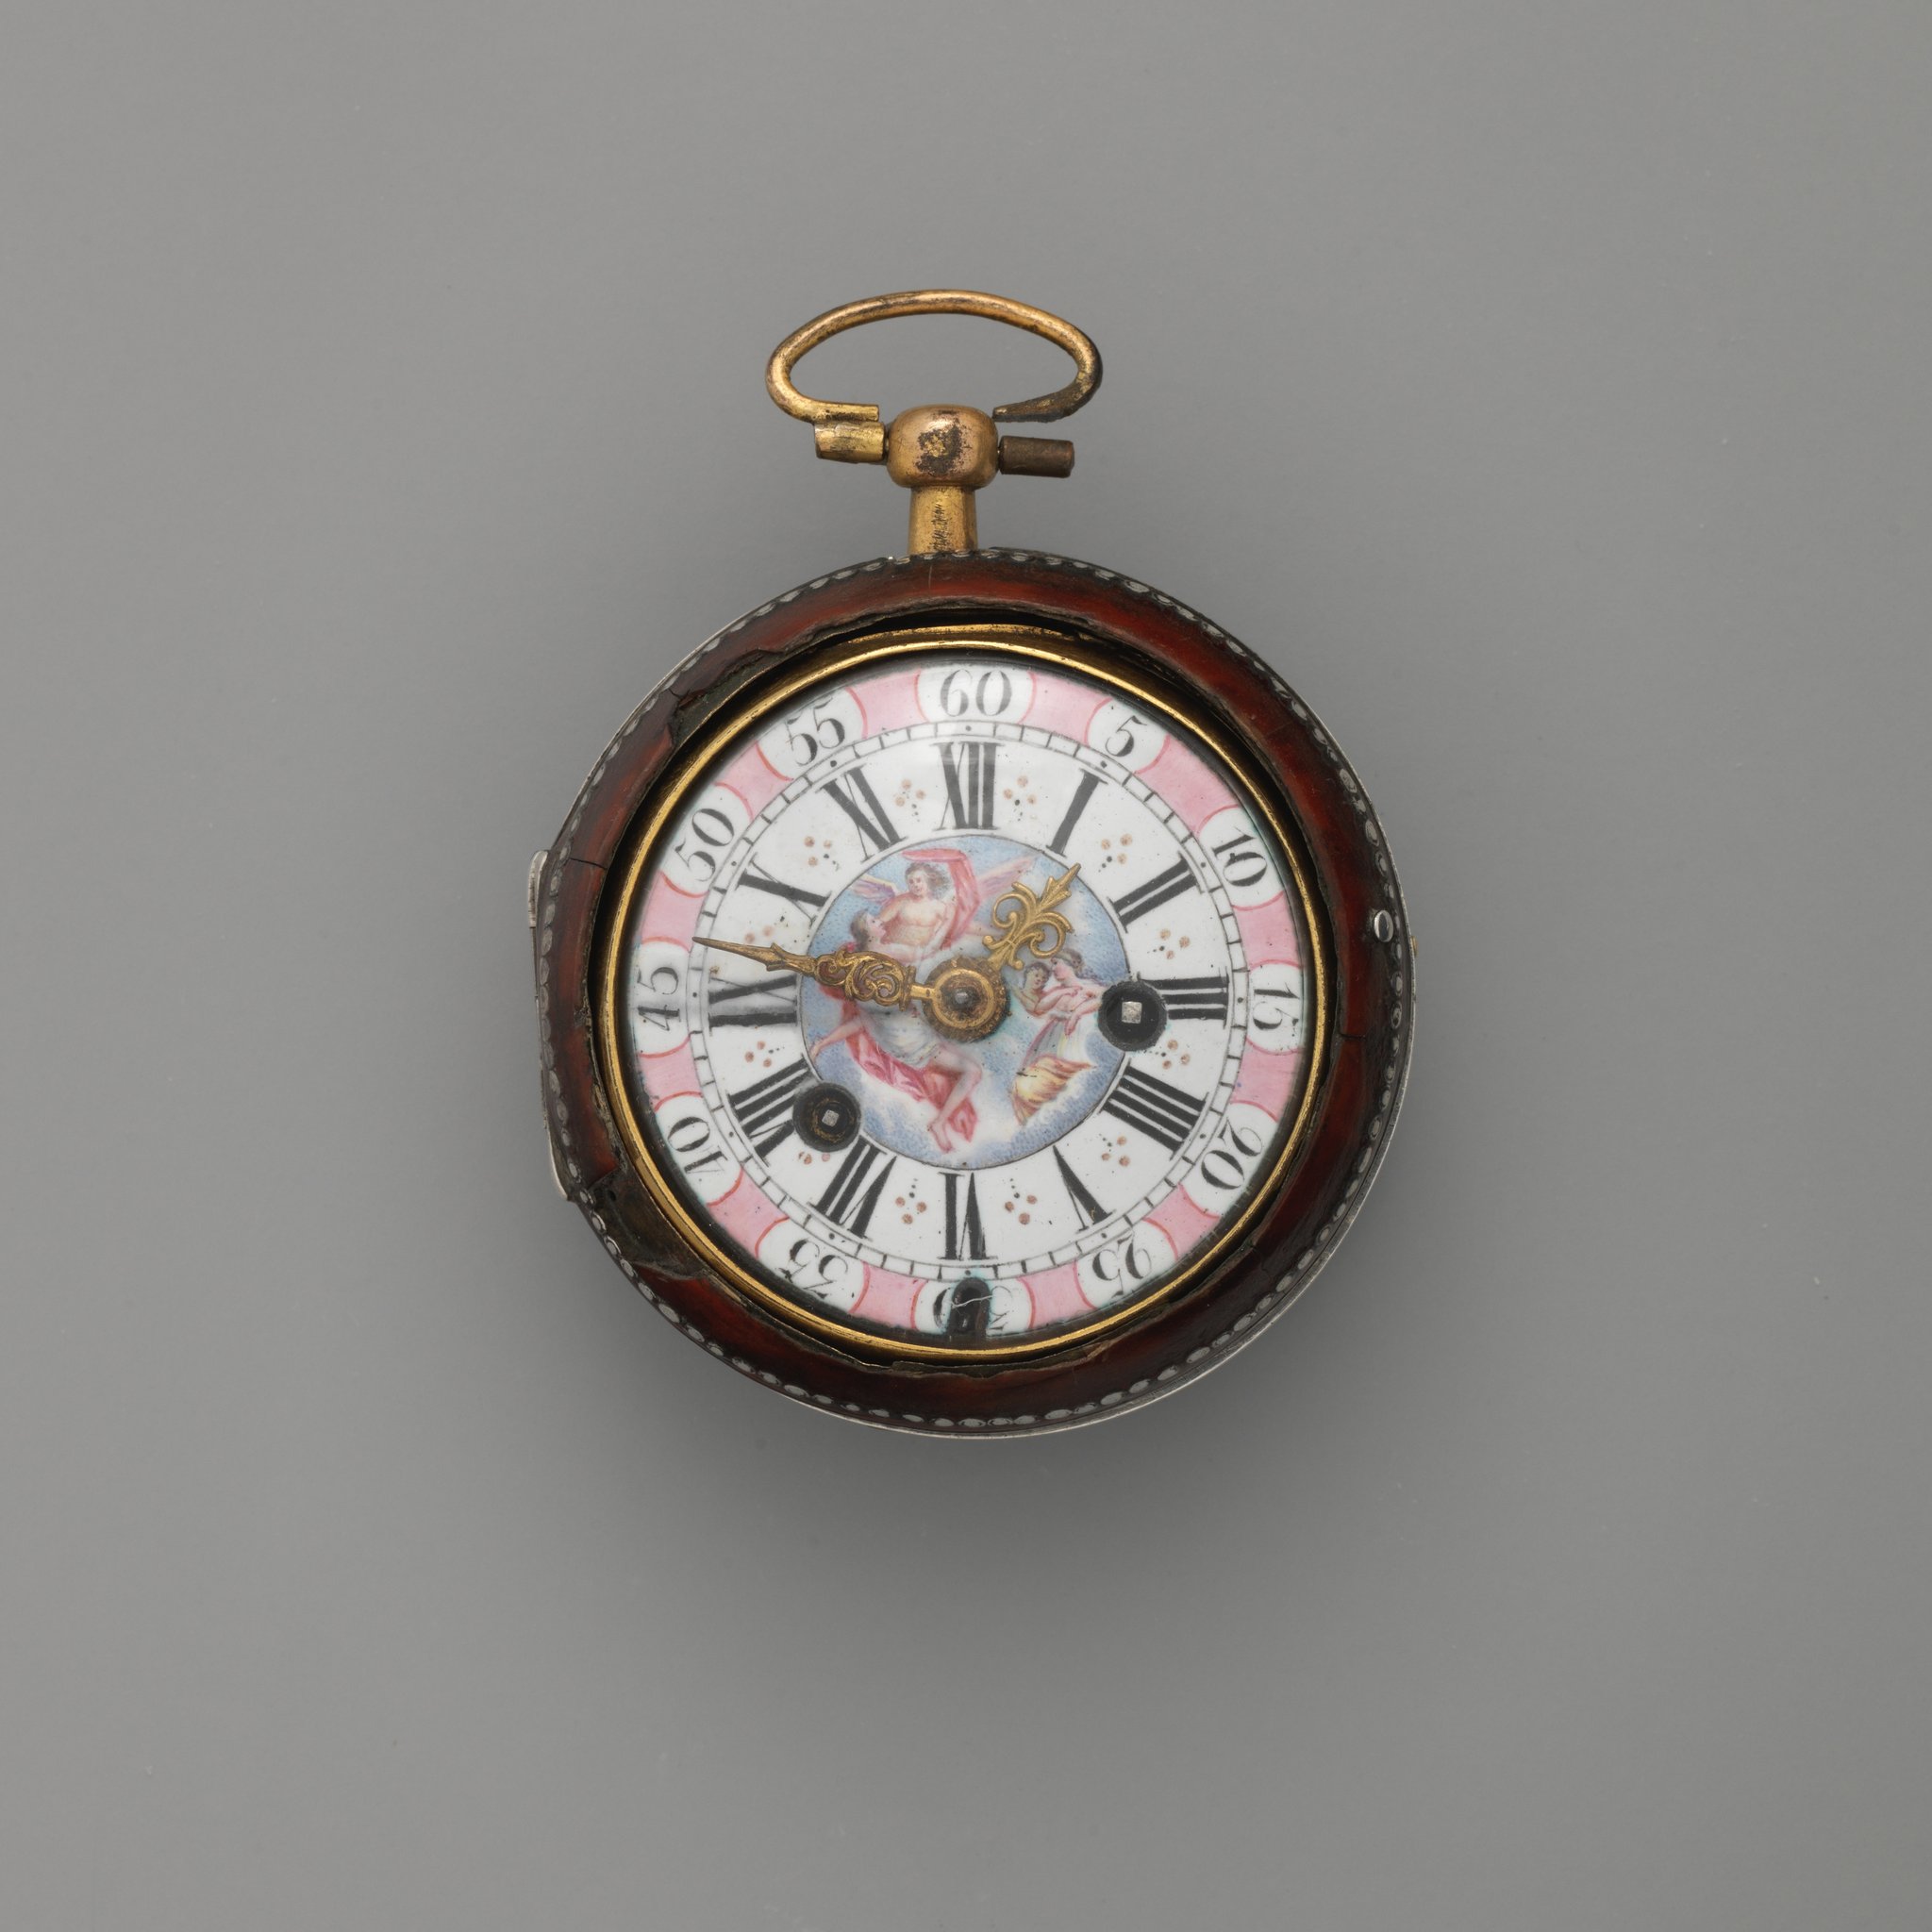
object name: repeater watch and case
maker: thomas tompion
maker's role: maker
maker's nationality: british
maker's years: 1639-1713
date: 1682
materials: enamel, gilt, metal, silver, shell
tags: women